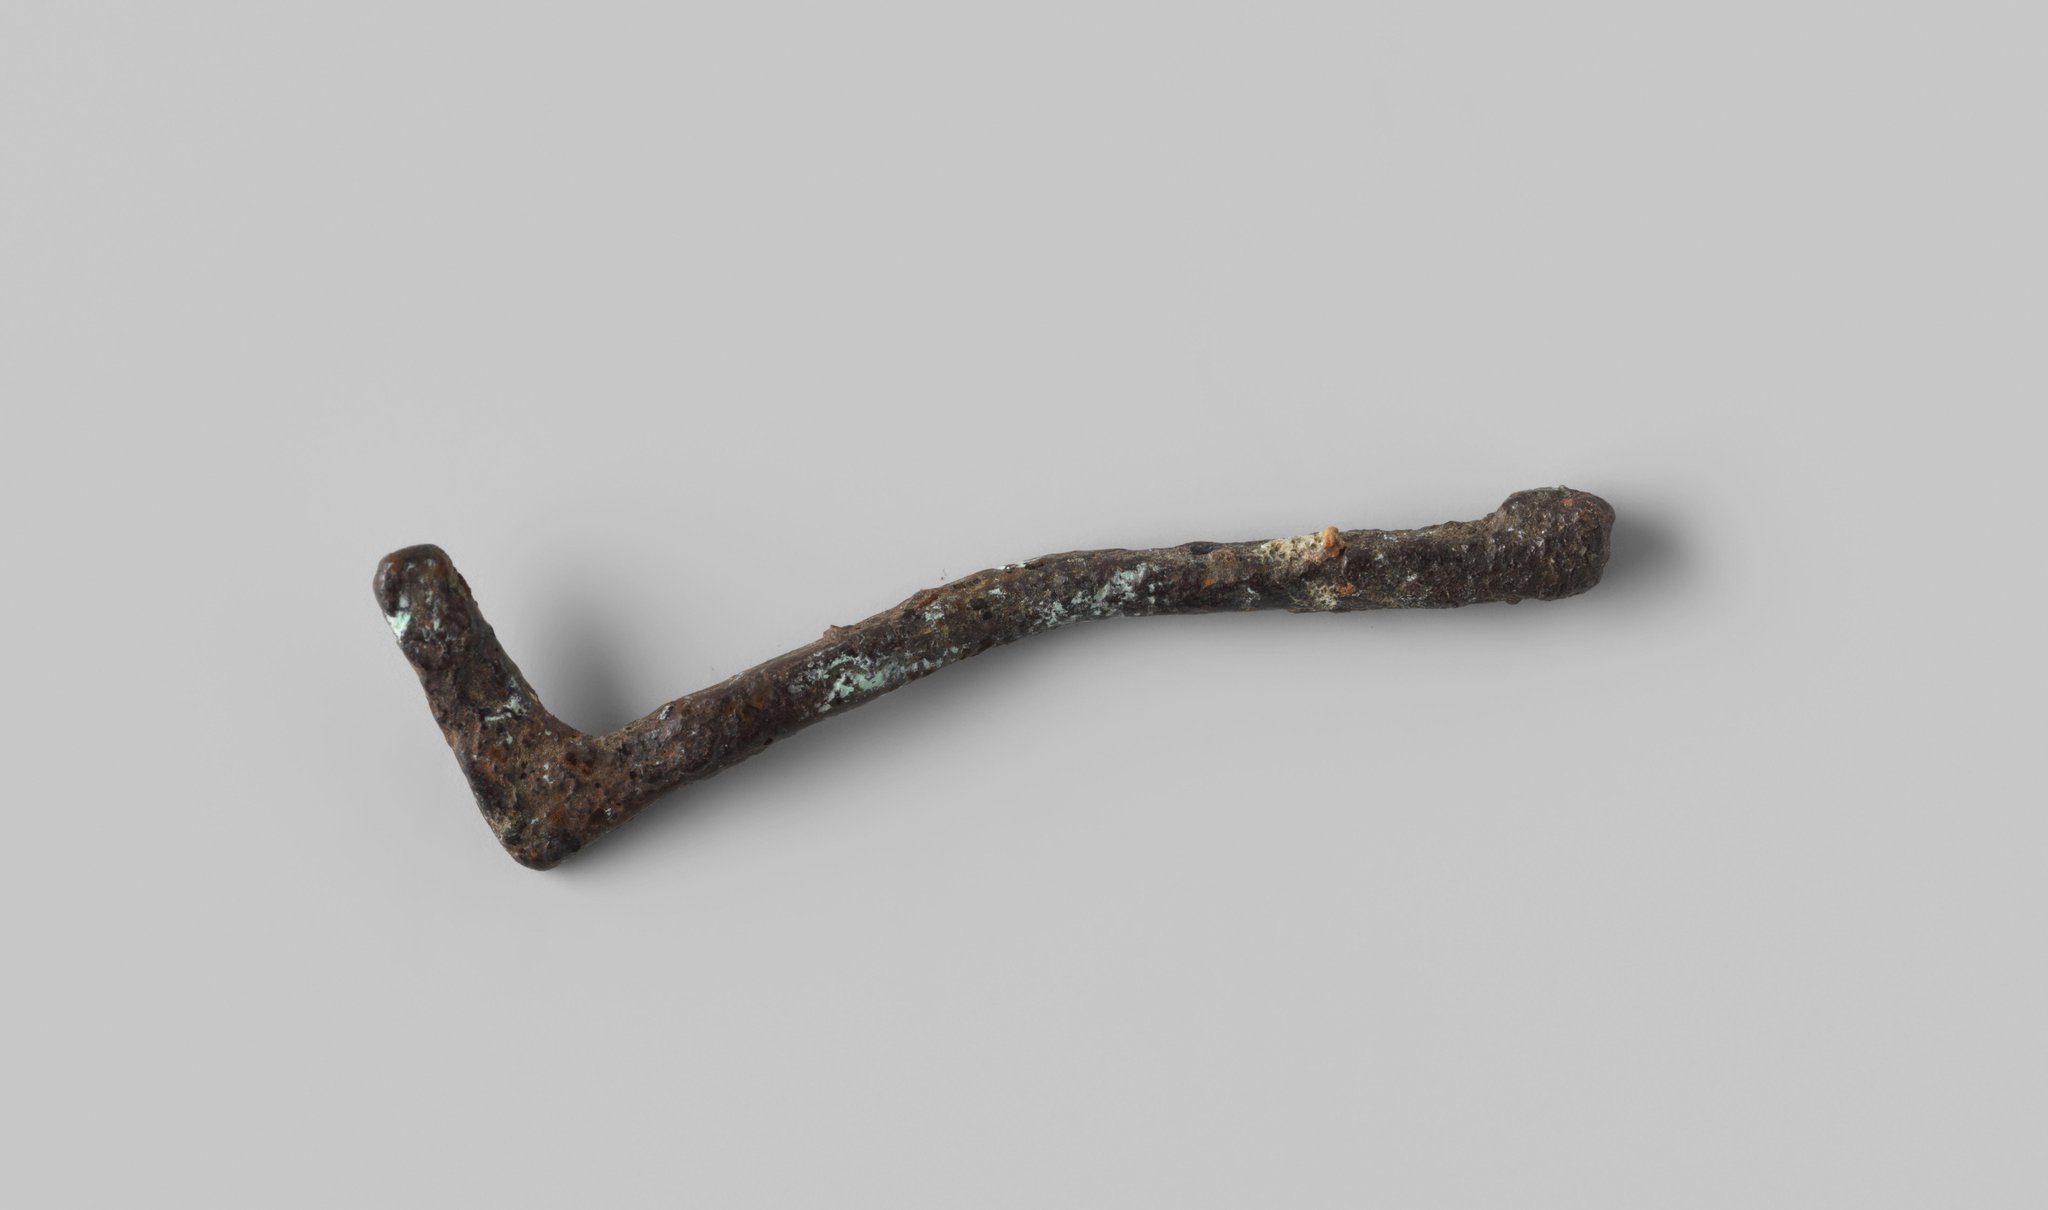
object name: belt buckle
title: Fragment riemgesp uit het wrak van de Oost-Indiëvaarder Hollandia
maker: Anonymous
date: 1700-1743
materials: copper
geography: netherlands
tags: verenigde oostindische compagnie, hollandia (schip), annet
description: D-shaped, fragm of ring, id. NG 1979-182H2177, belt buckle.